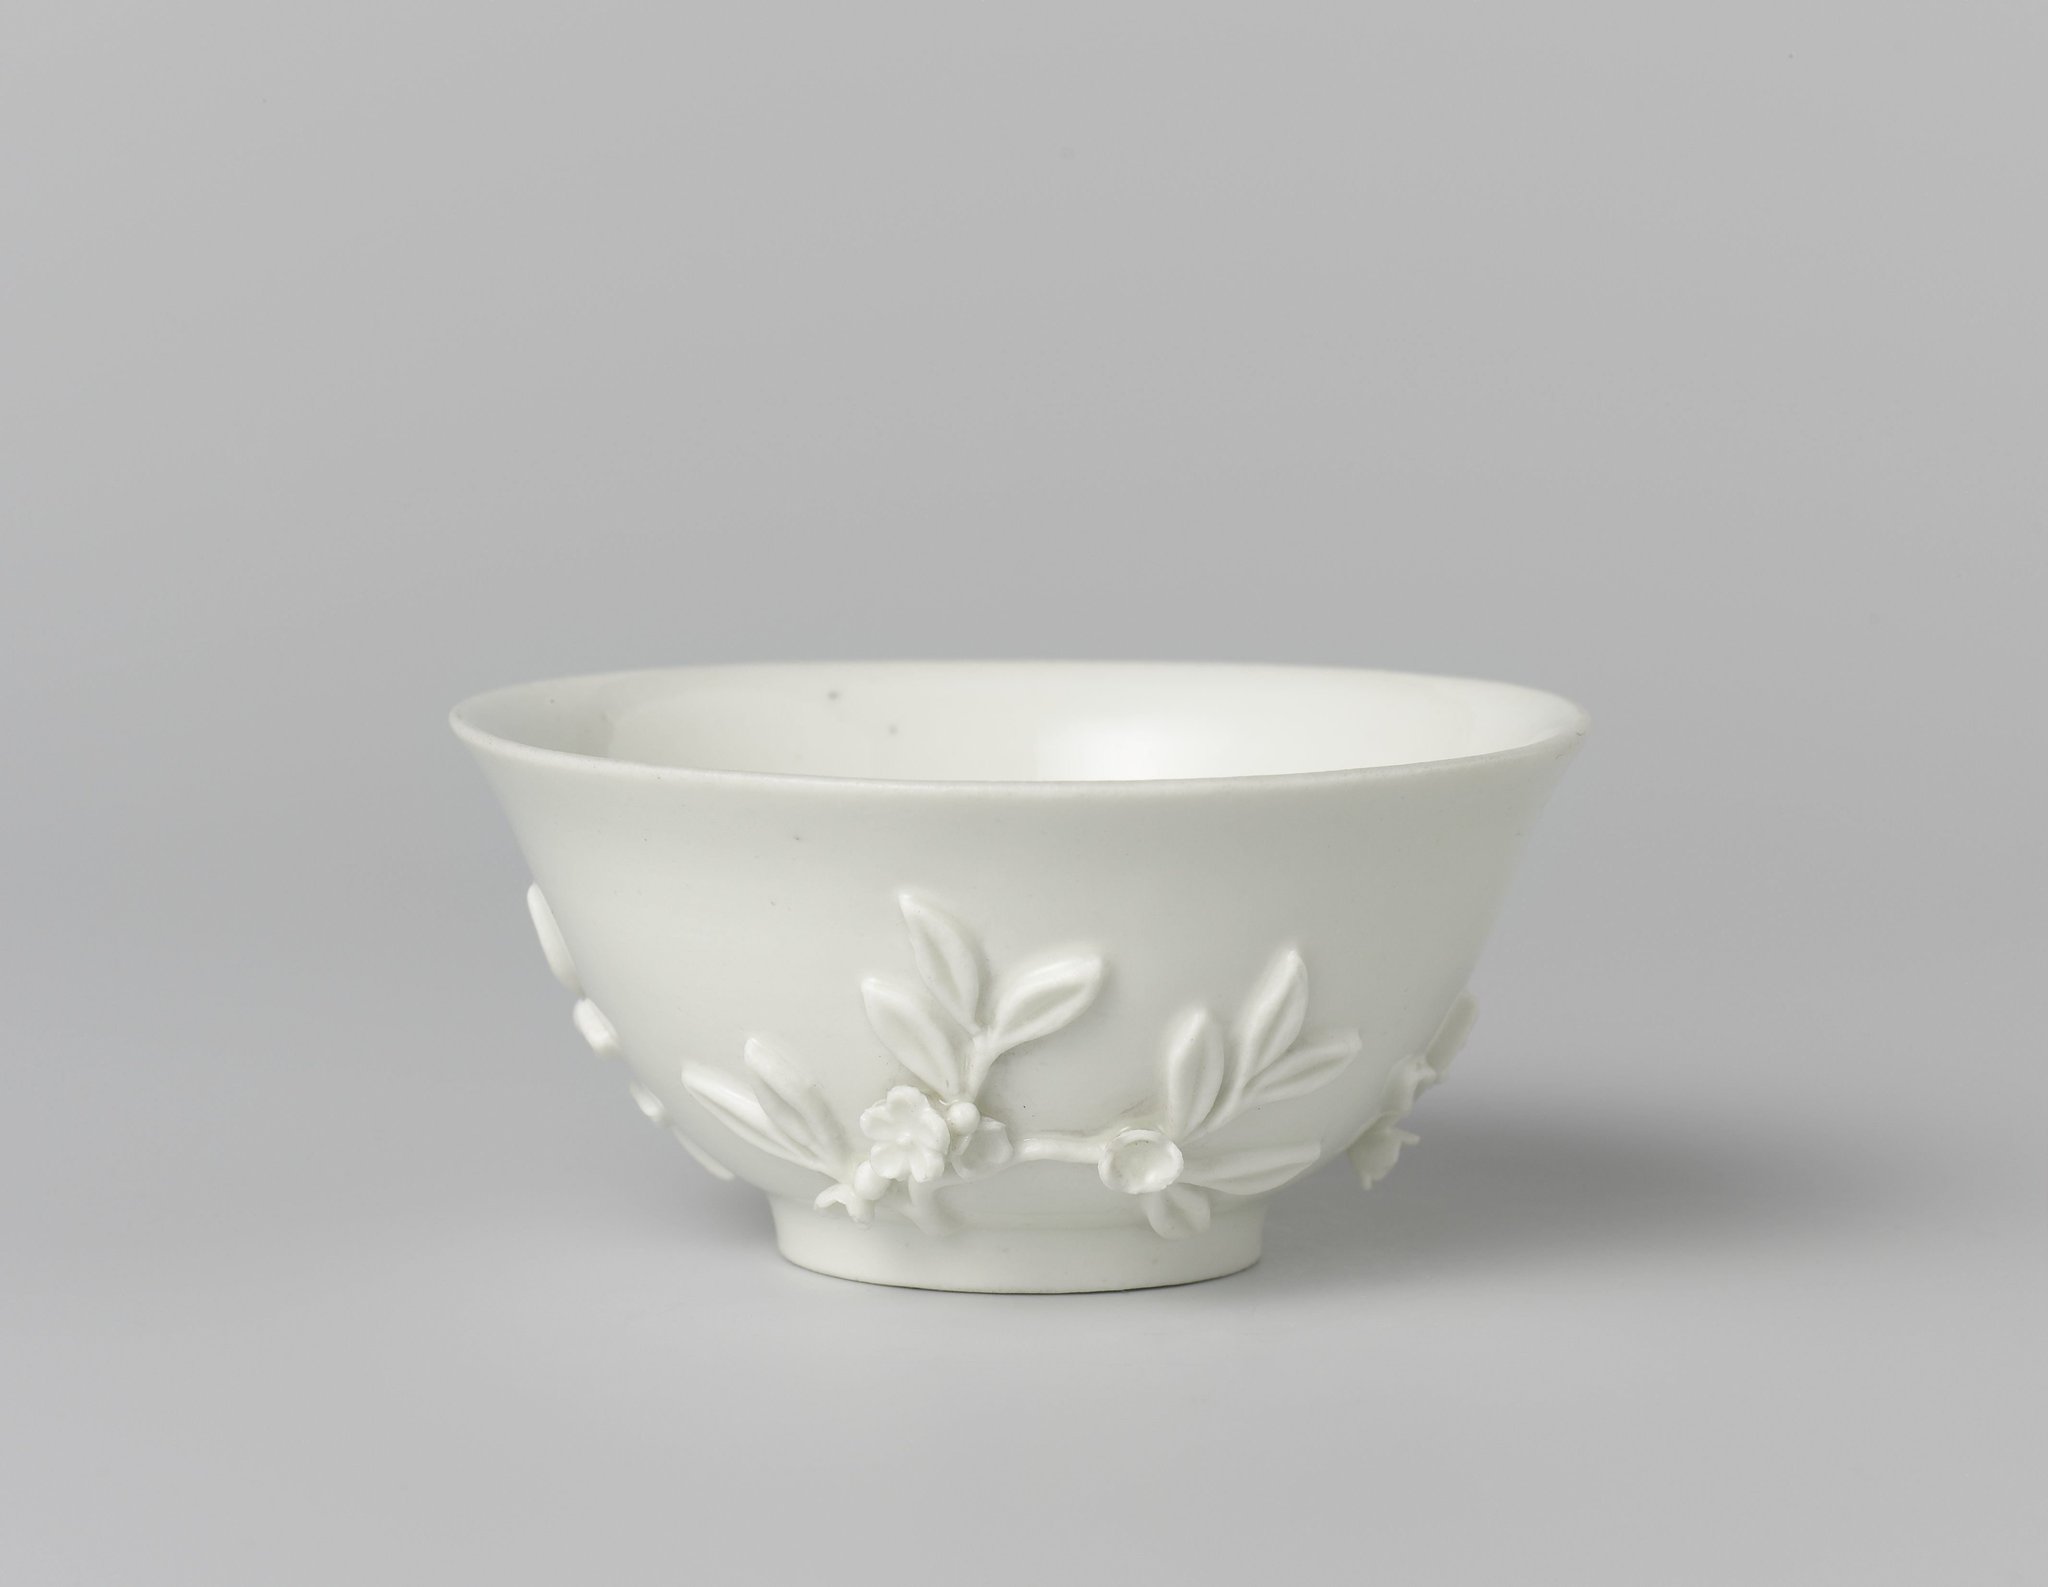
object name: eating drinking utensil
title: Two cups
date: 1715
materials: porcelain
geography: meissen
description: Meissener Porzellan Manufaktur Meissen, c. 1715 hard-paste porcelain